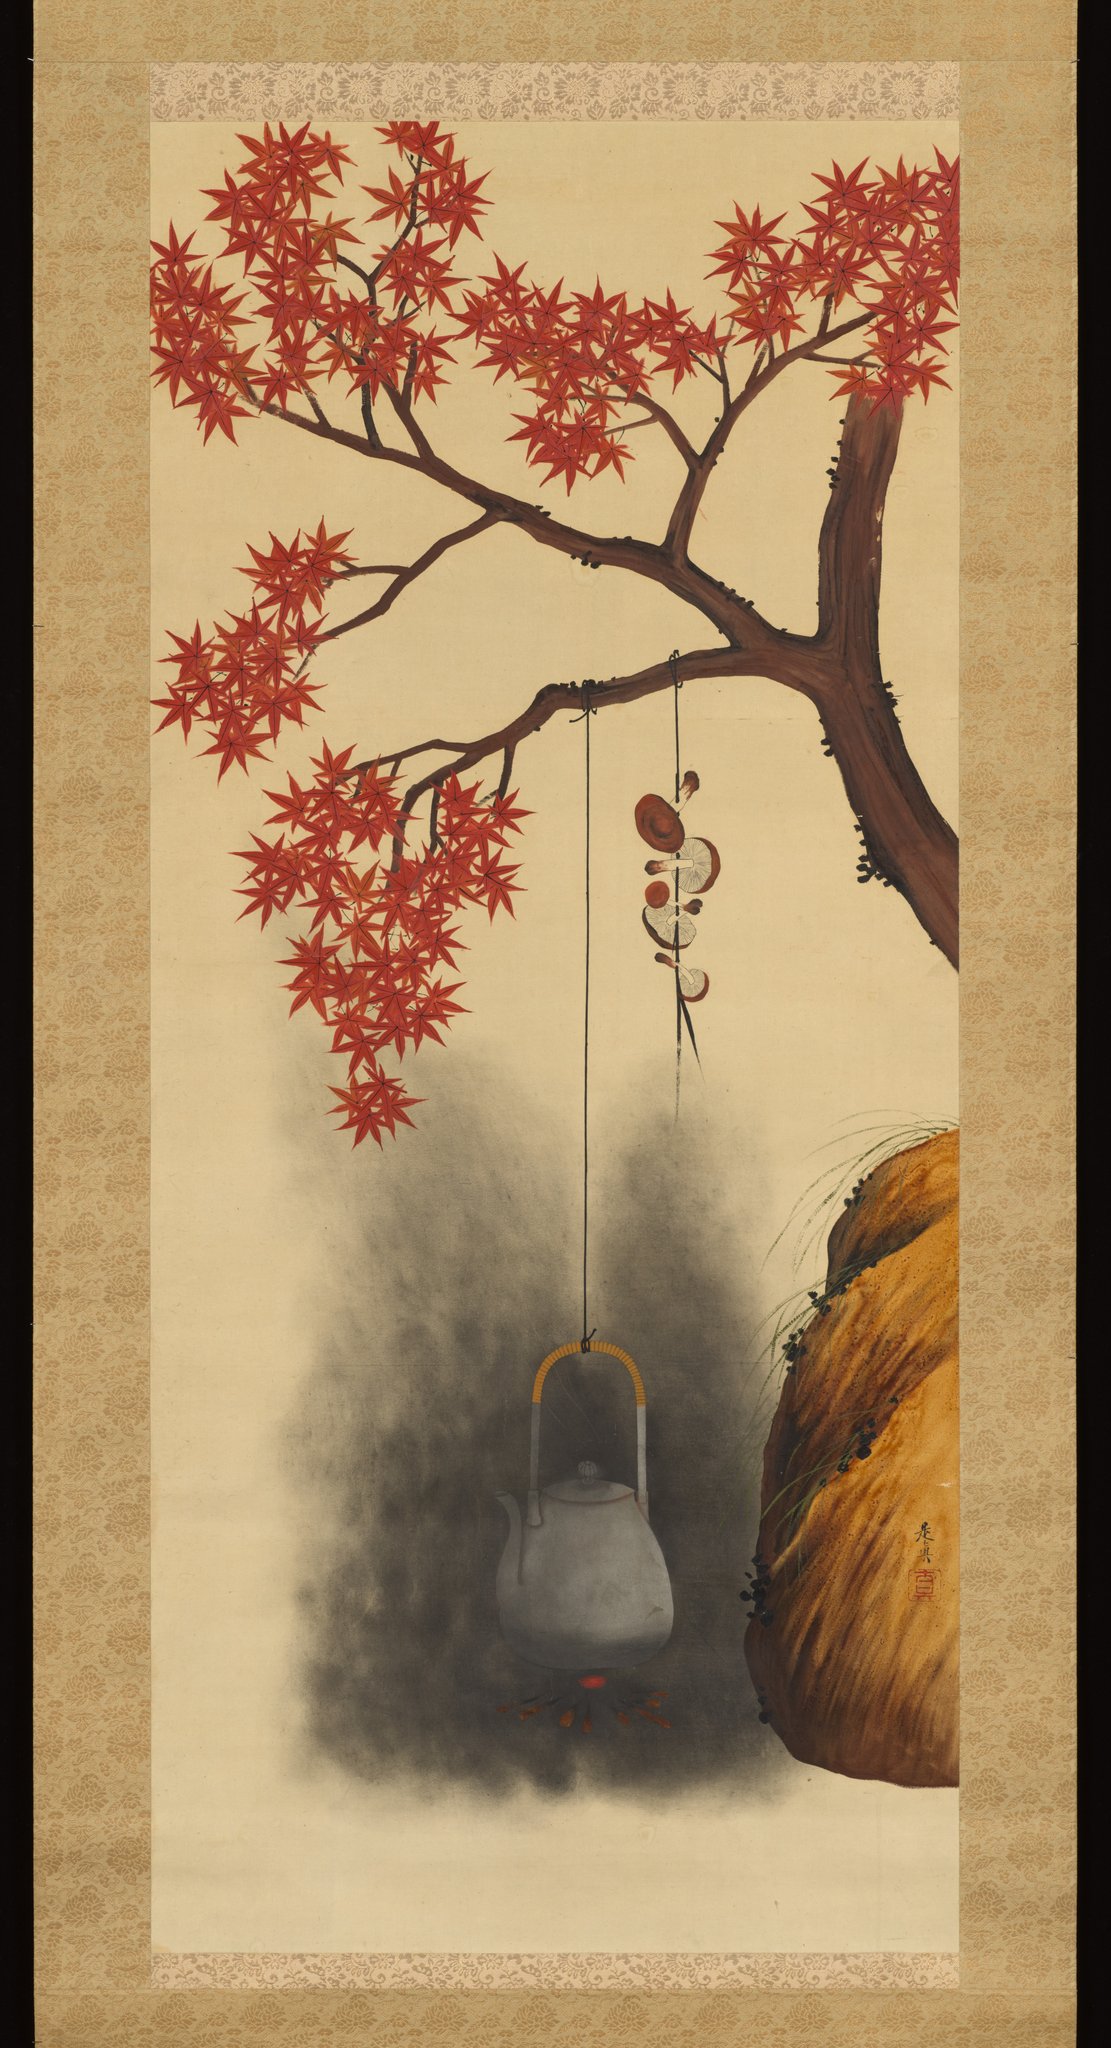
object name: hanging scroll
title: Autumn Maple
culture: japanese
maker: shibata zeshin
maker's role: artist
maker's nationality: japanese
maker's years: 1807-1891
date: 1867-1900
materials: silk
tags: trees,kettles